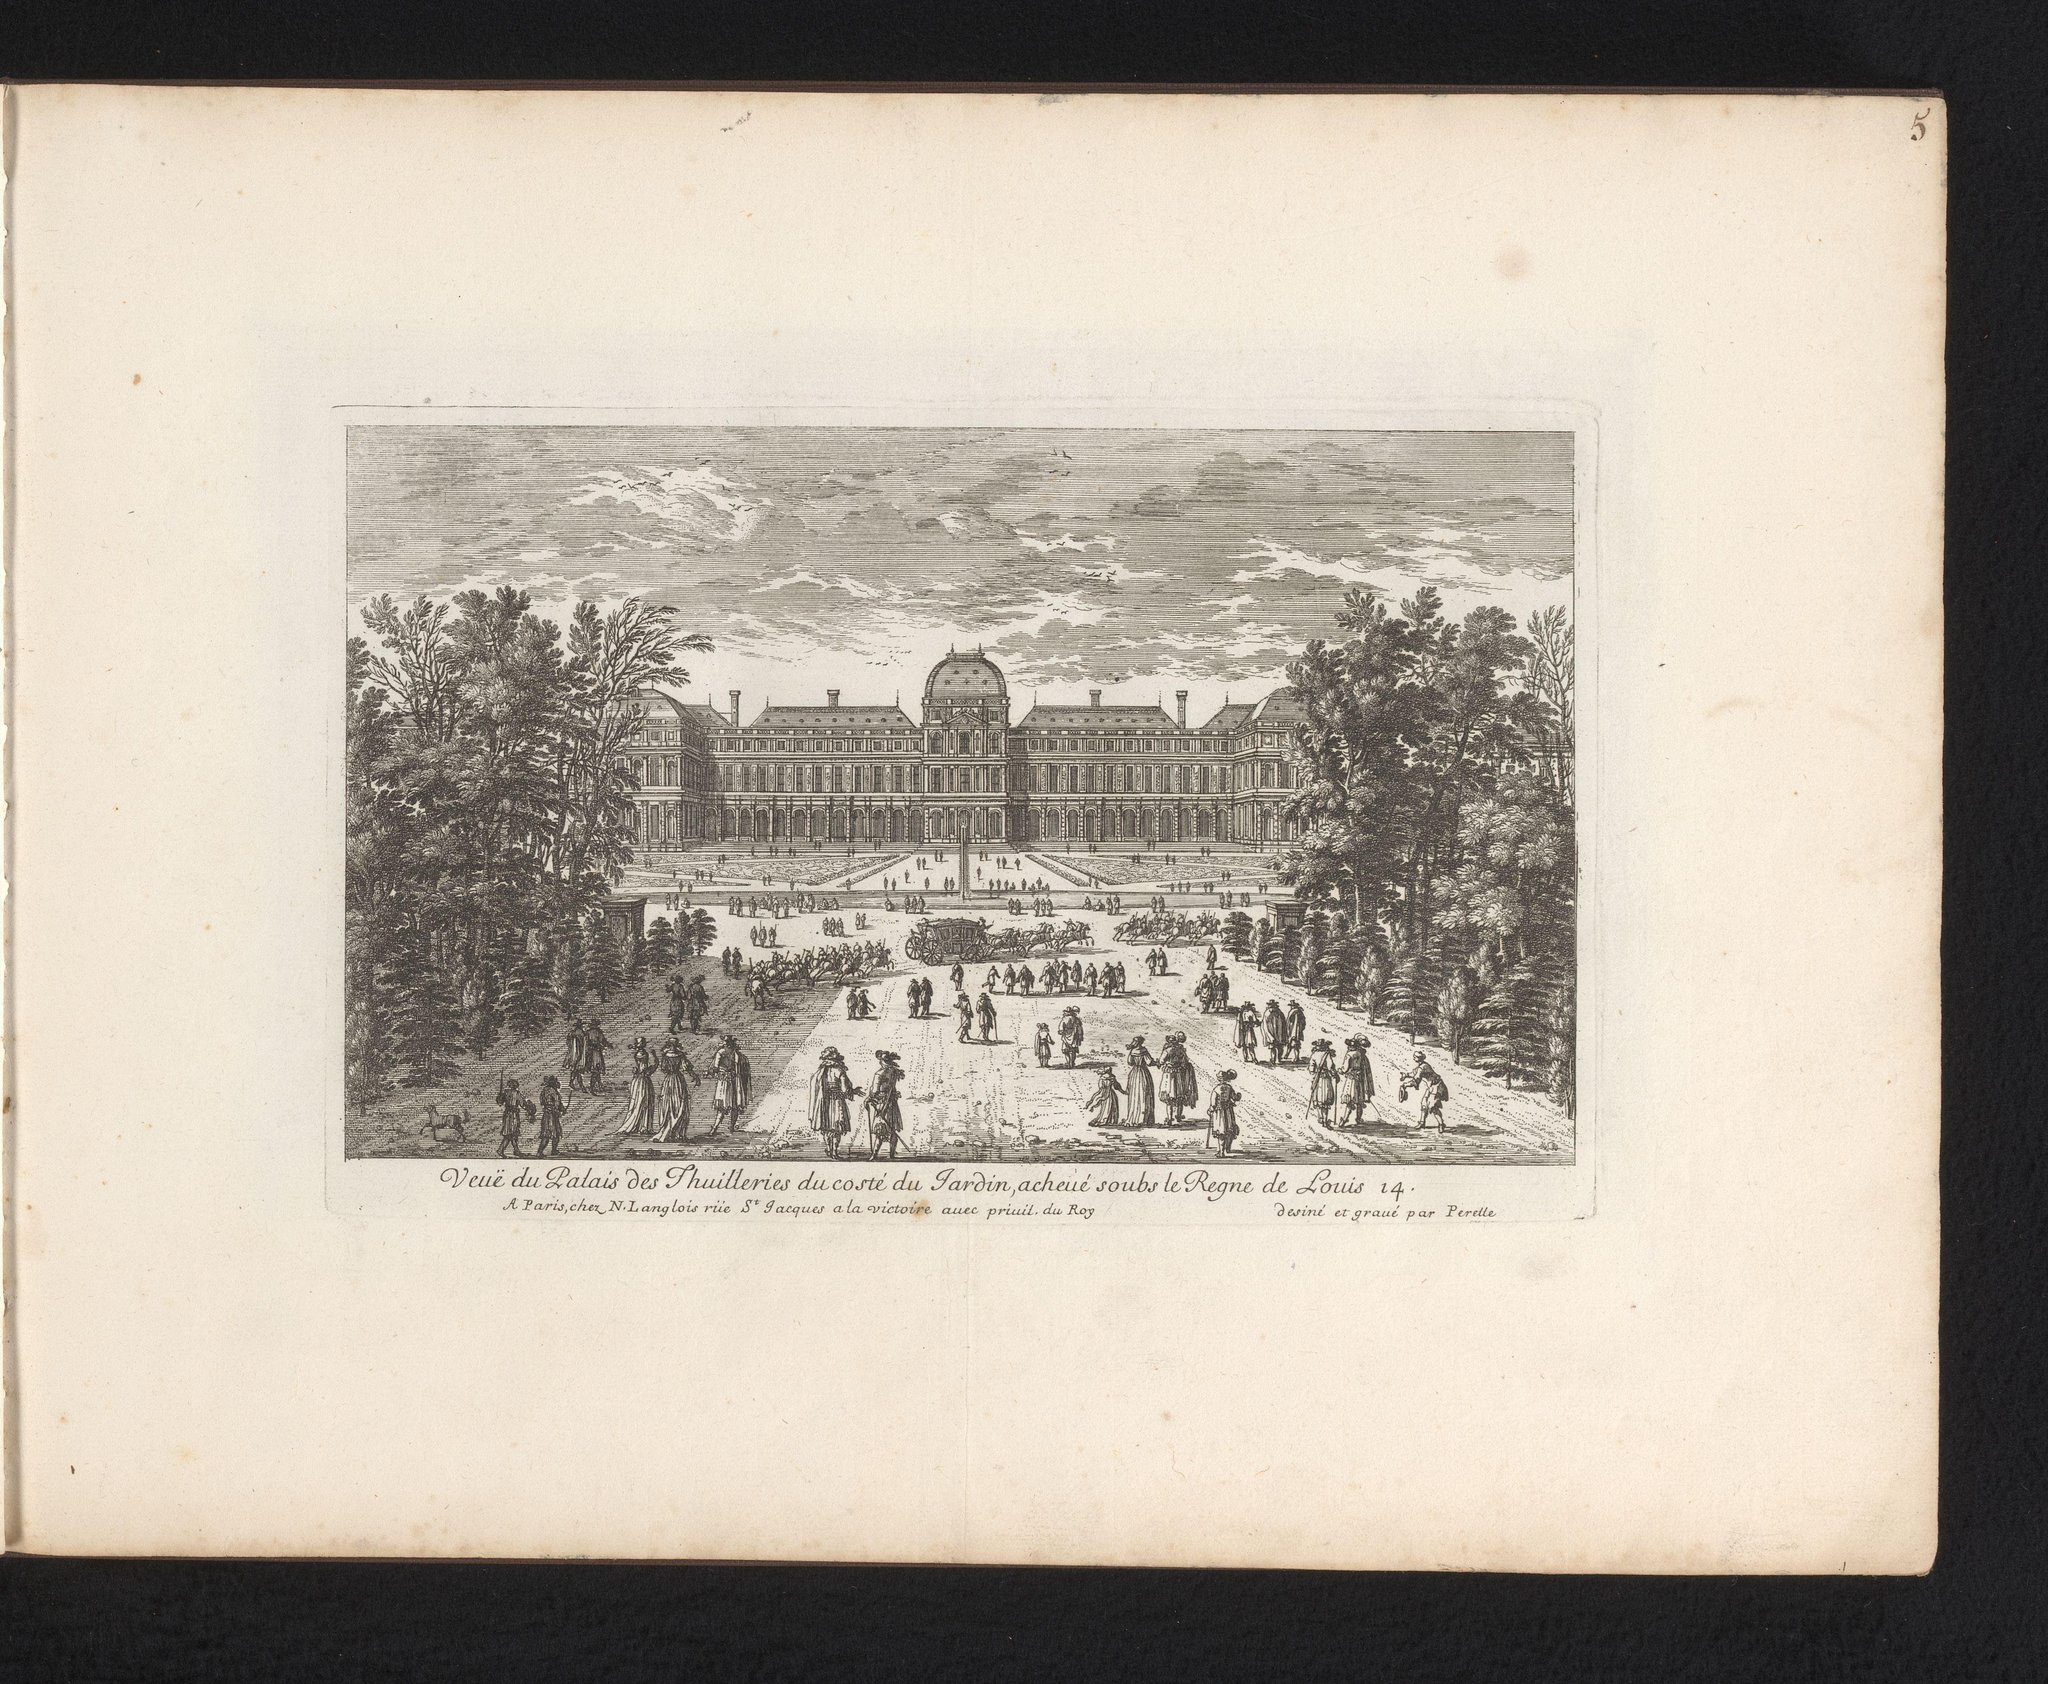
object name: album leaf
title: Recueil de vues de monuments de Paris, des principales résidences royales et des principaux châteaux de France et de Rome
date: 1660-1695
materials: paper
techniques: etching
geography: france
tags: palace, french or architectonic garden; formal garden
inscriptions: collector's mark: Lugt 2228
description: Prenten met het signatuur 'Perelle' kunnen zowel door vader Gabriel als door zonen Nicolas en Adam gemaakt zijn. De uitgevers vader en zoon Nicolas Langlois worden allebei vermeld als N. Langlois op hetzelfde adres.